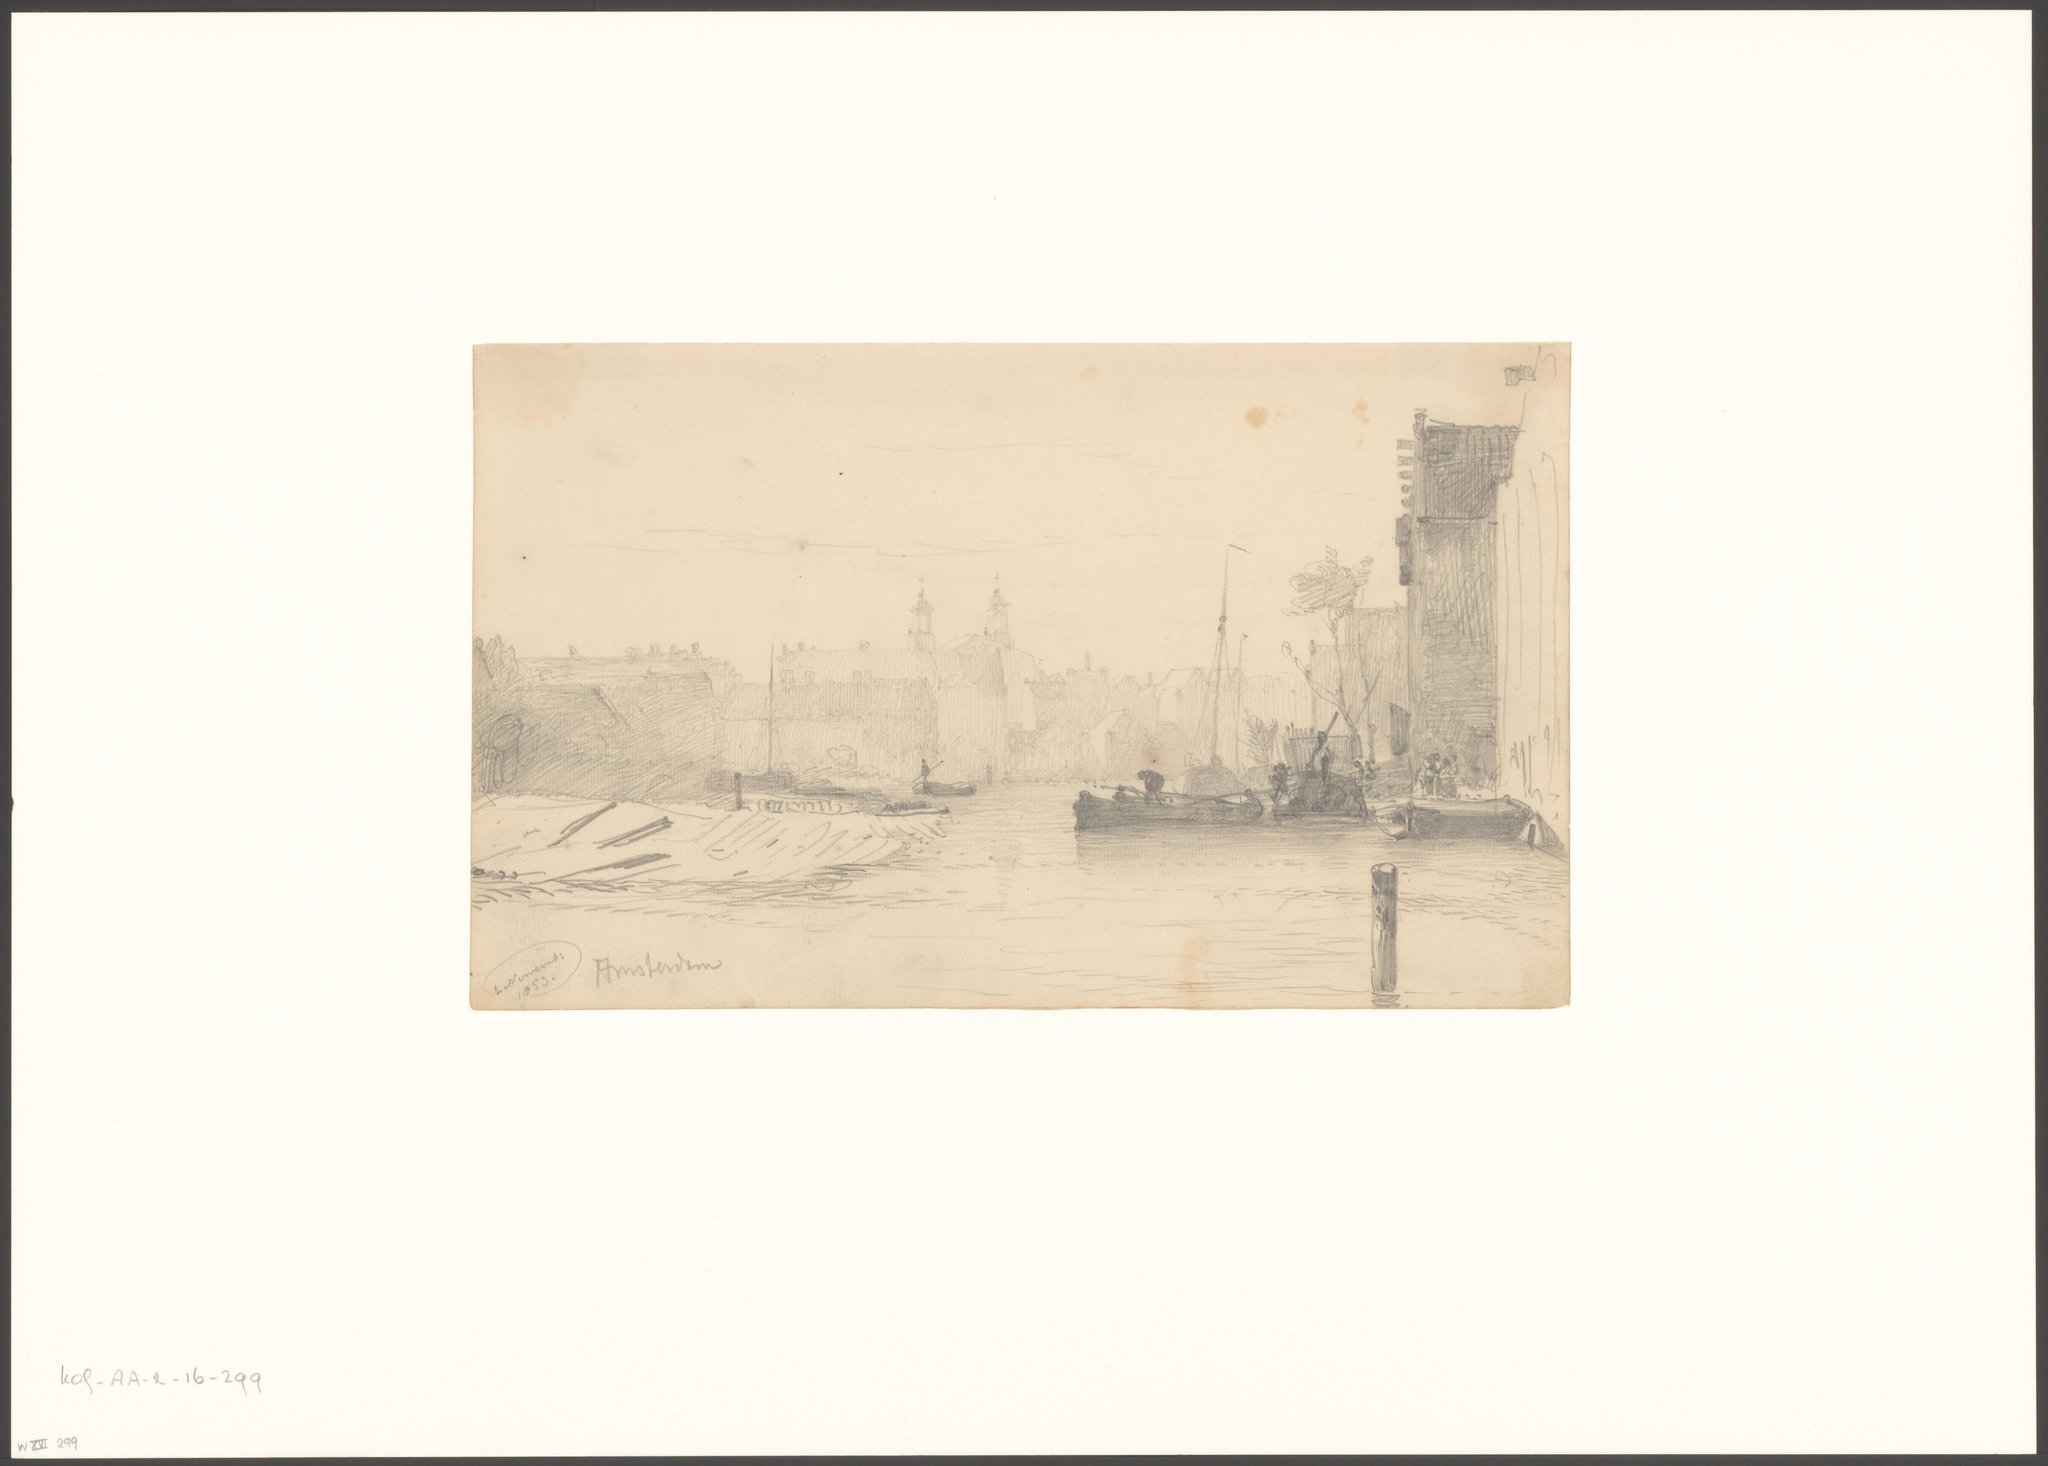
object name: drawing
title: Gezicht op de Markengracht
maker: willem anthonie van deventer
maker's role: draughtsman, painter, print maker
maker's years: 1824-1893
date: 1853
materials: paper, pencil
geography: amsterdam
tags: city-view in general; 'veduta', canal, boat propelled by man or animal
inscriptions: date: ‘2 November / 1853. / Amsterdam’, collector's mark: Lugt 800a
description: Tekening binnen de Atlas Van Eck ingedeeld op wijknummer 16.